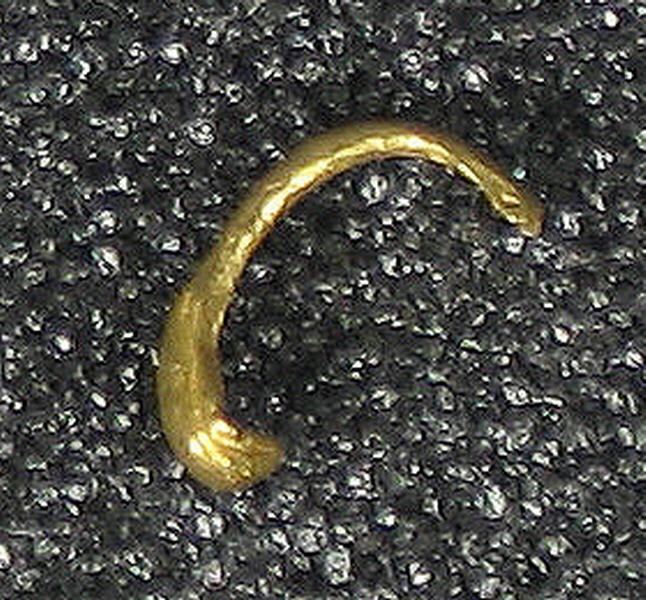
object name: ornament fragment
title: Fragment of an Ornament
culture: indonesian, central java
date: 701-1200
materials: gold